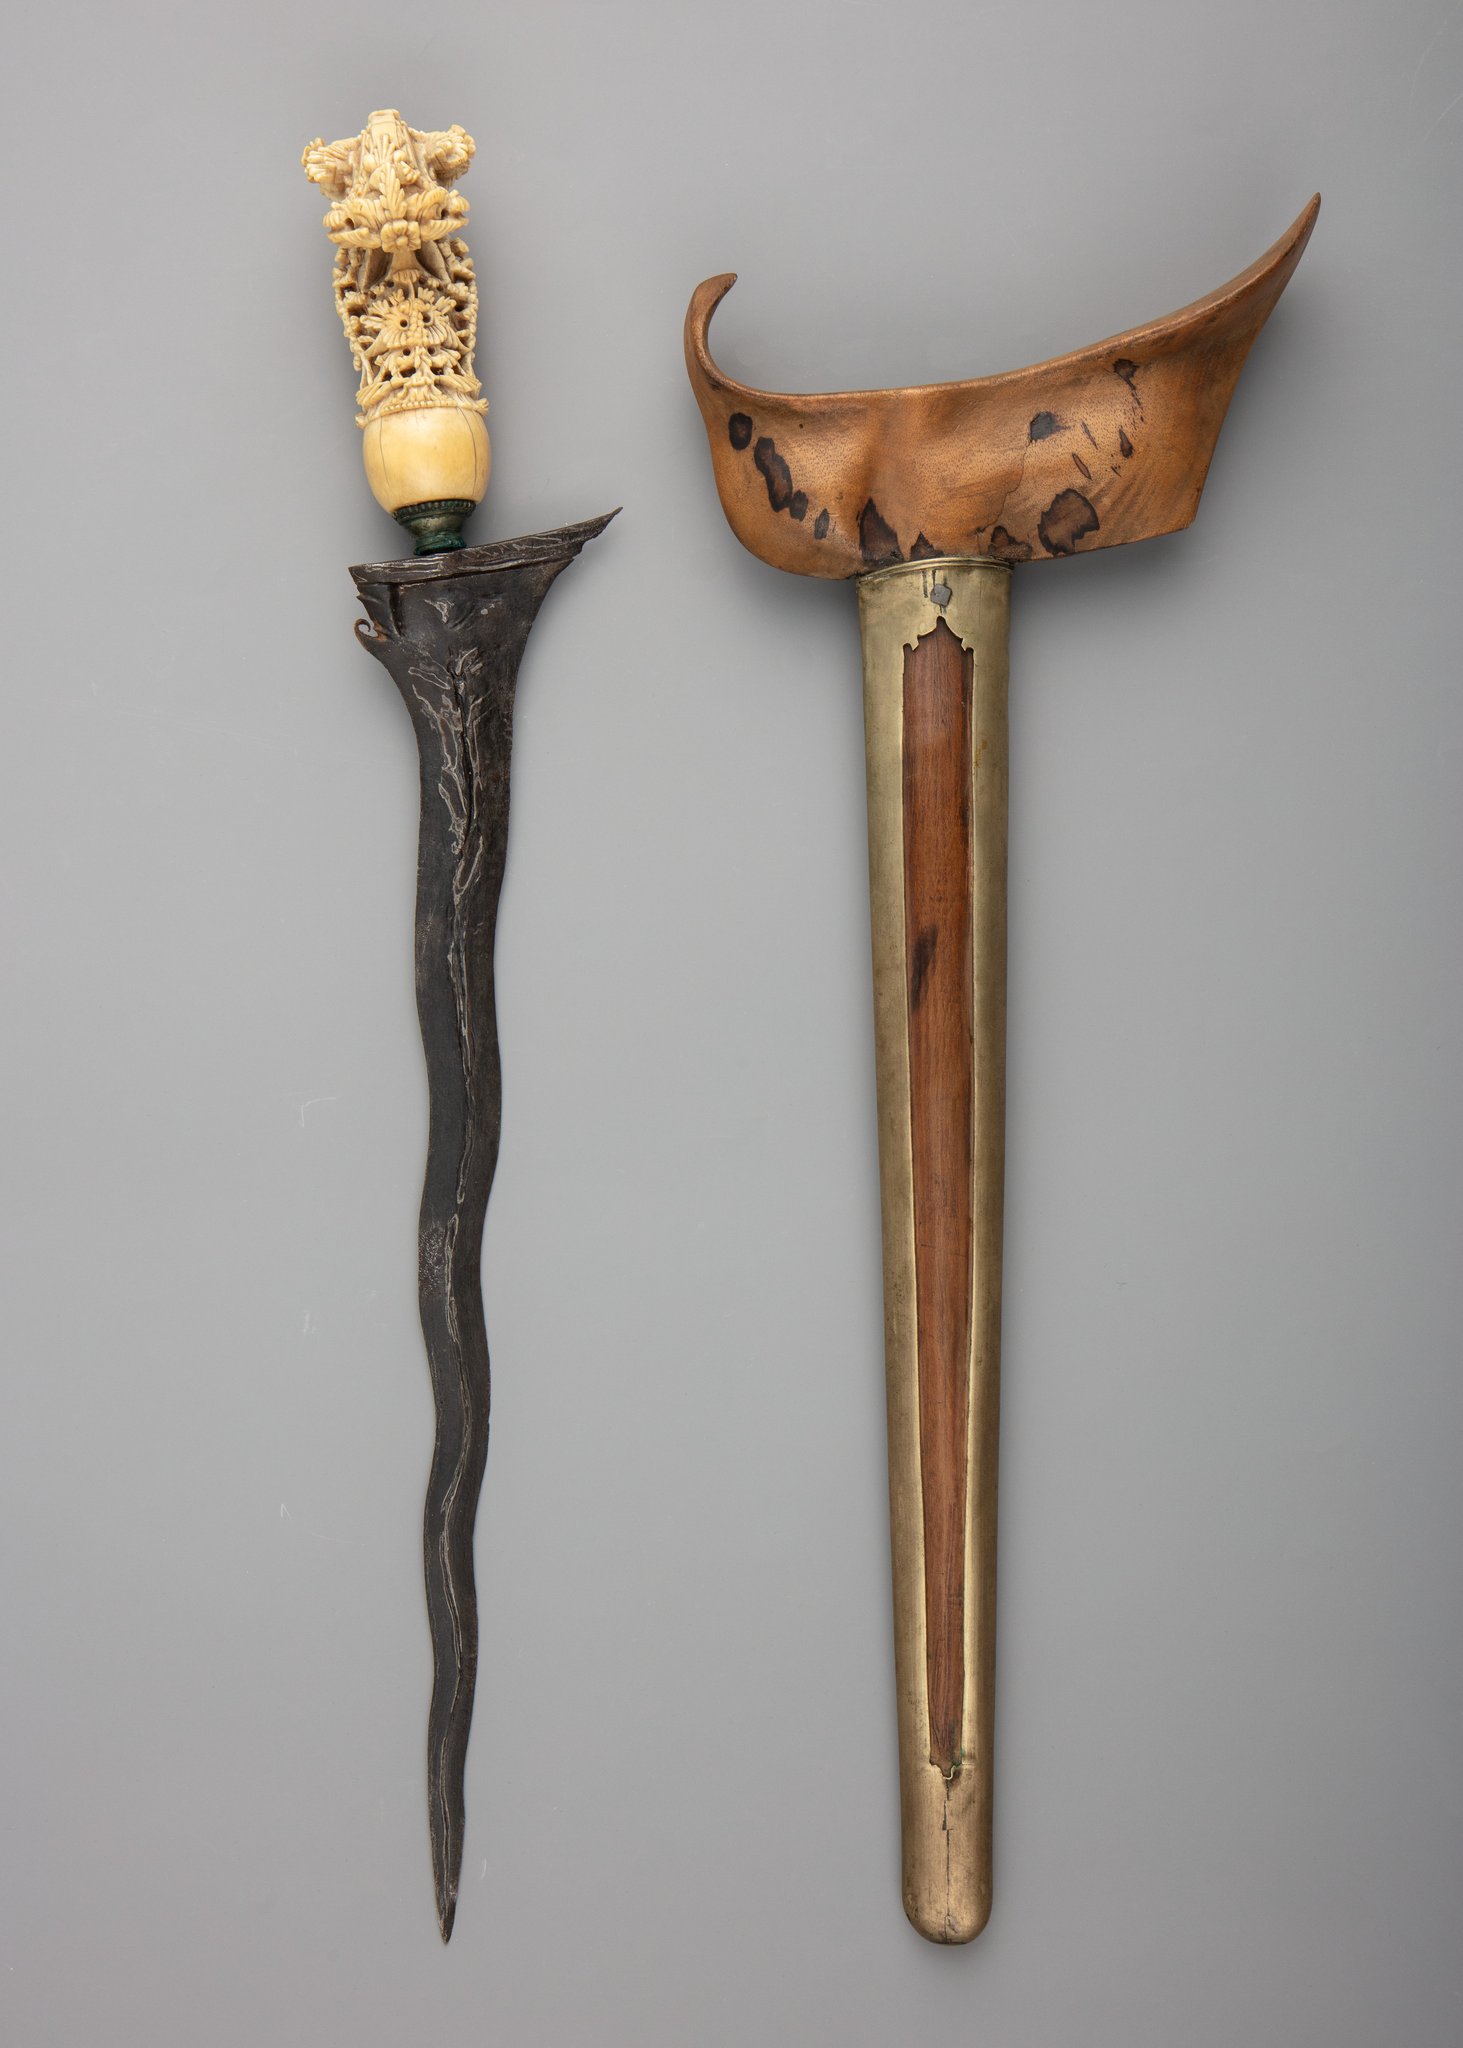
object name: kris with sheath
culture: madurese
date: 1701-1900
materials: copper alloy, ivory, steel, wood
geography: indonesia